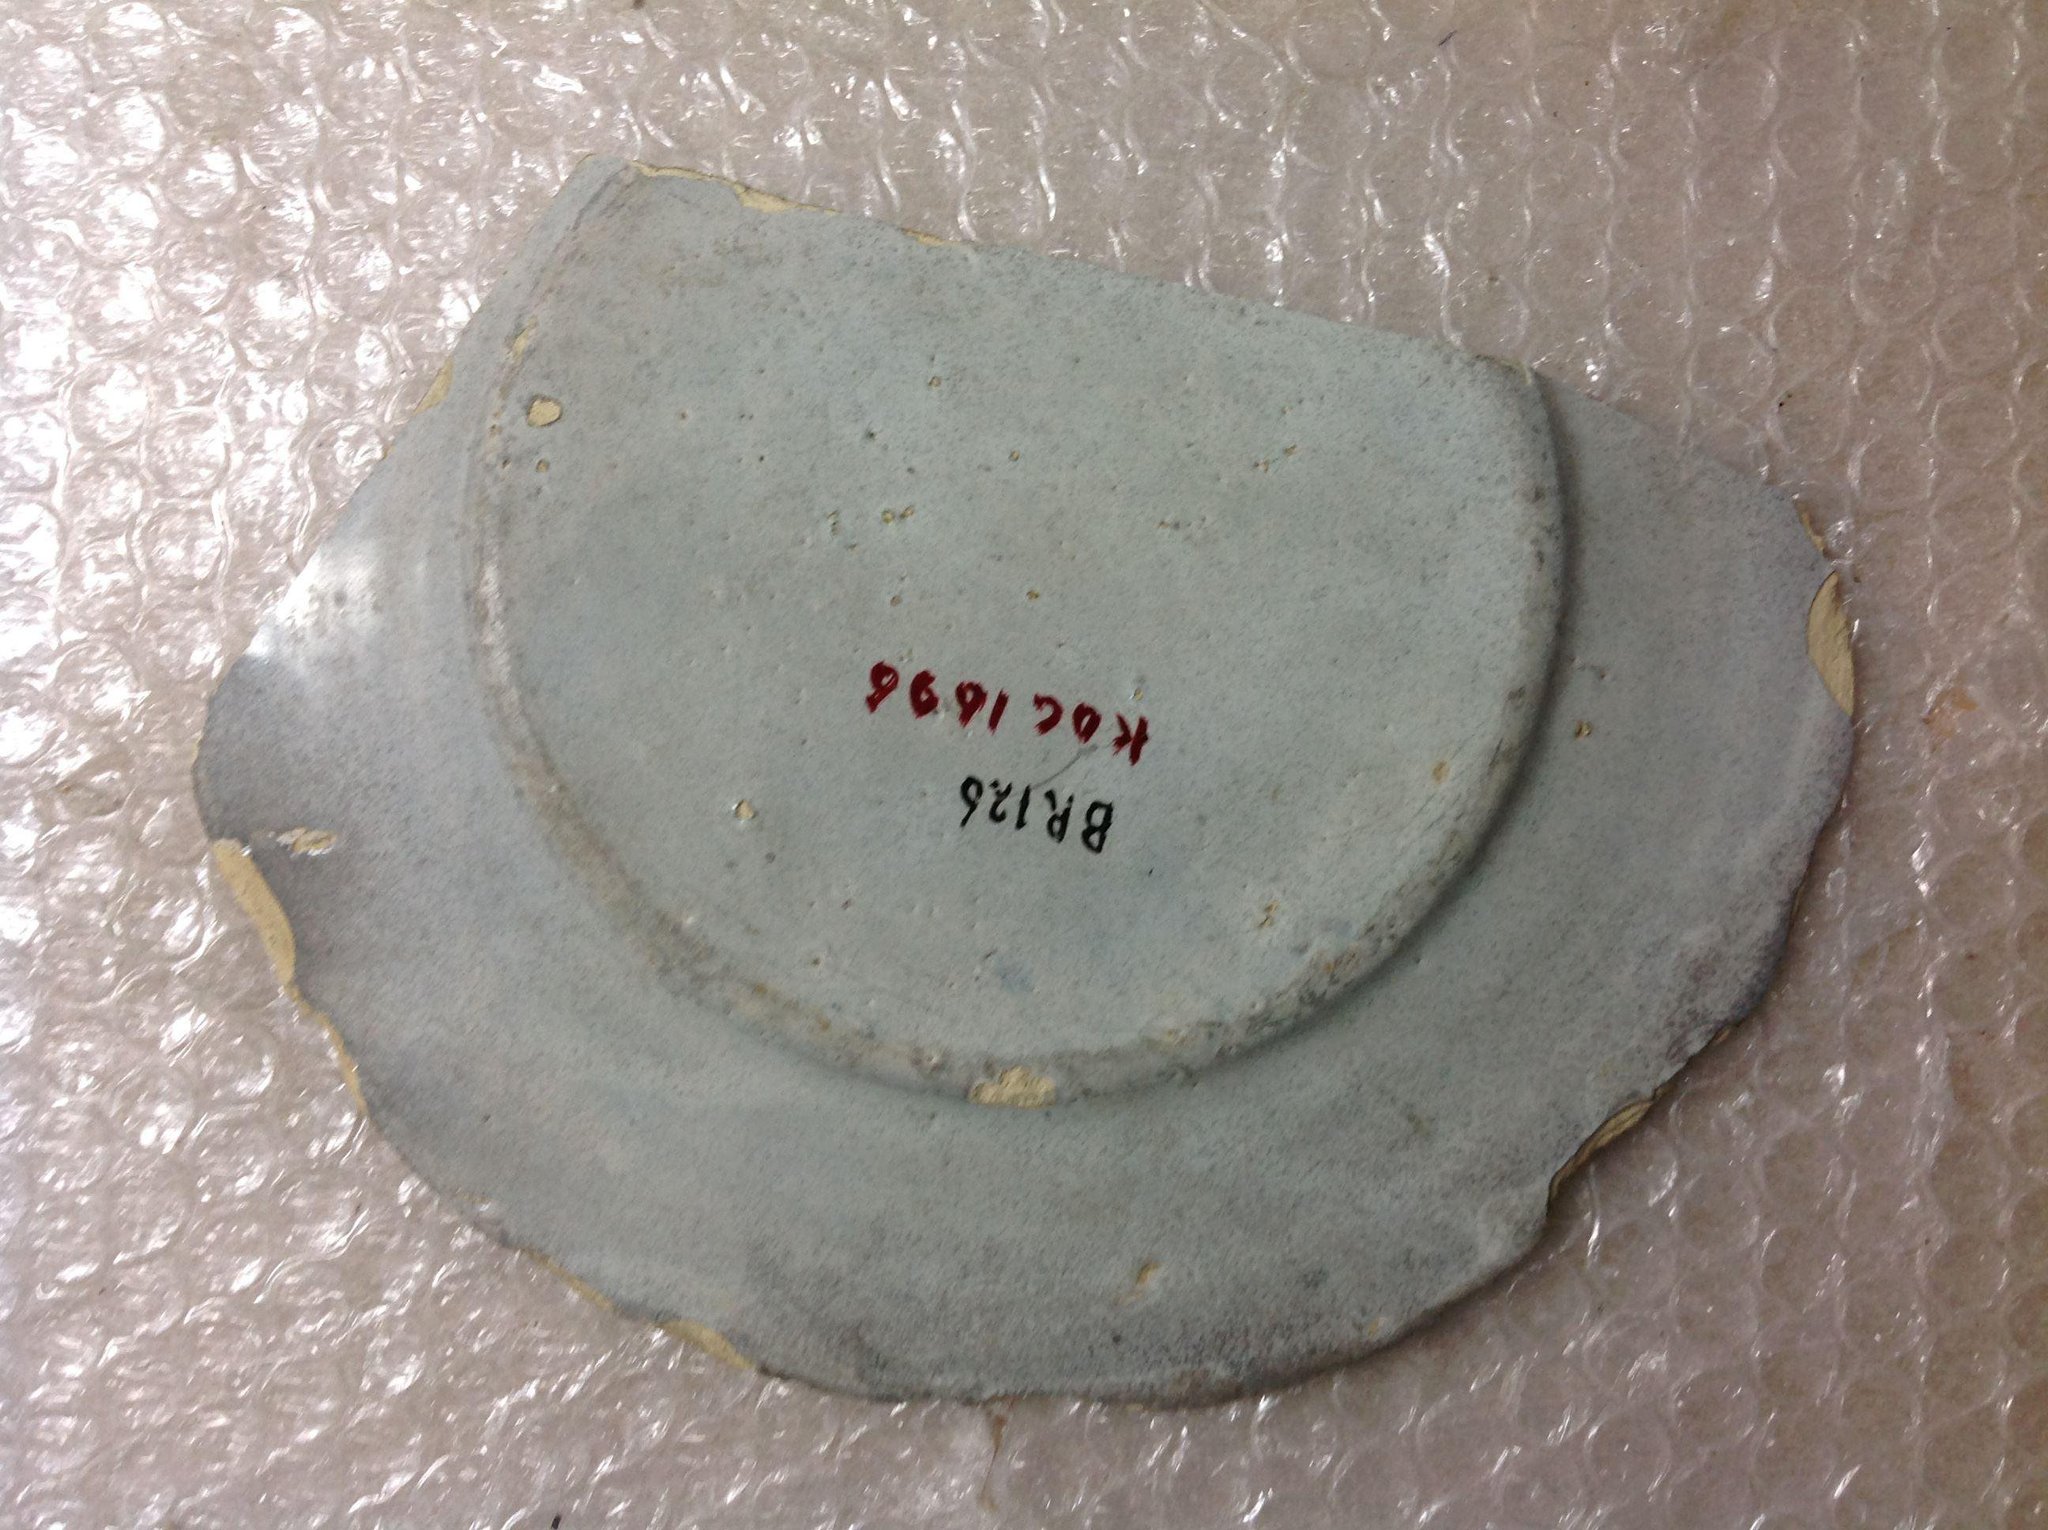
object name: tabakspijp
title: Gemerkte tabakspijp van pijpaarde, beschadigd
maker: Anonymous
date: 1500-1799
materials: clay